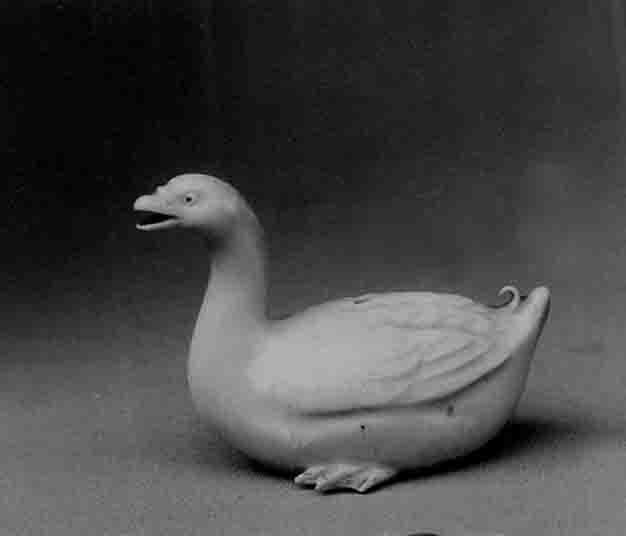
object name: water holder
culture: japanese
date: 1820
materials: porcelain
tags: ducks